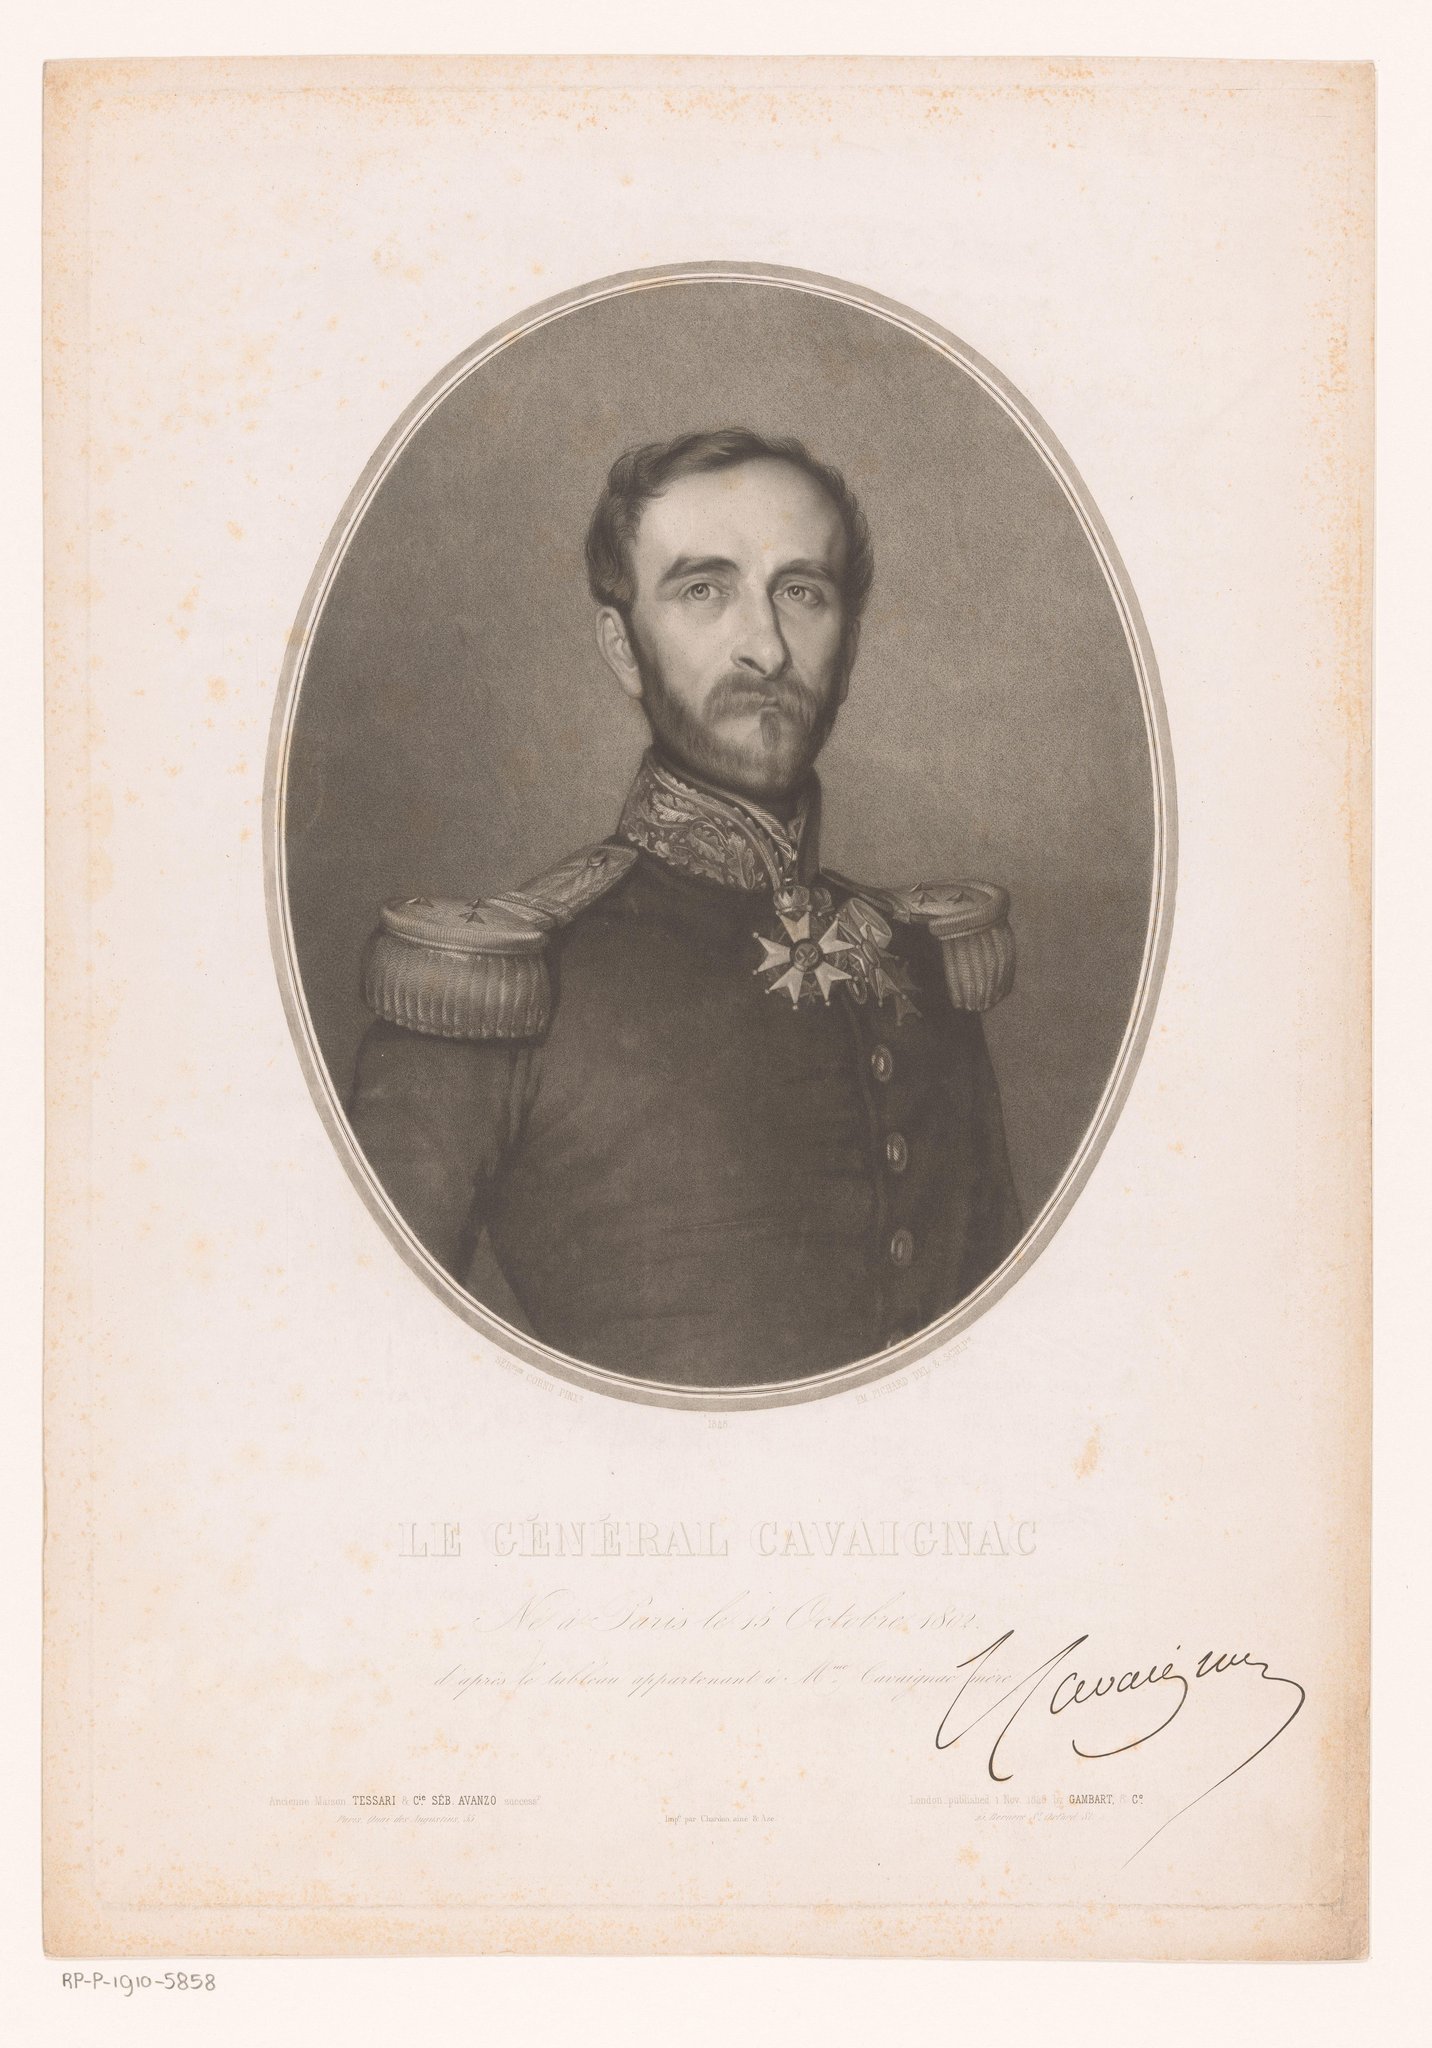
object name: print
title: Portret van Louis-Eugène Cavaignac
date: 1848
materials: paper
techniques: aquatint, etching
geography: london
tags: commander-in-chief, general, marshal, historical persons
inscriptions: collector's mark: Lugt 2228, signature: ‘LCavaignac’